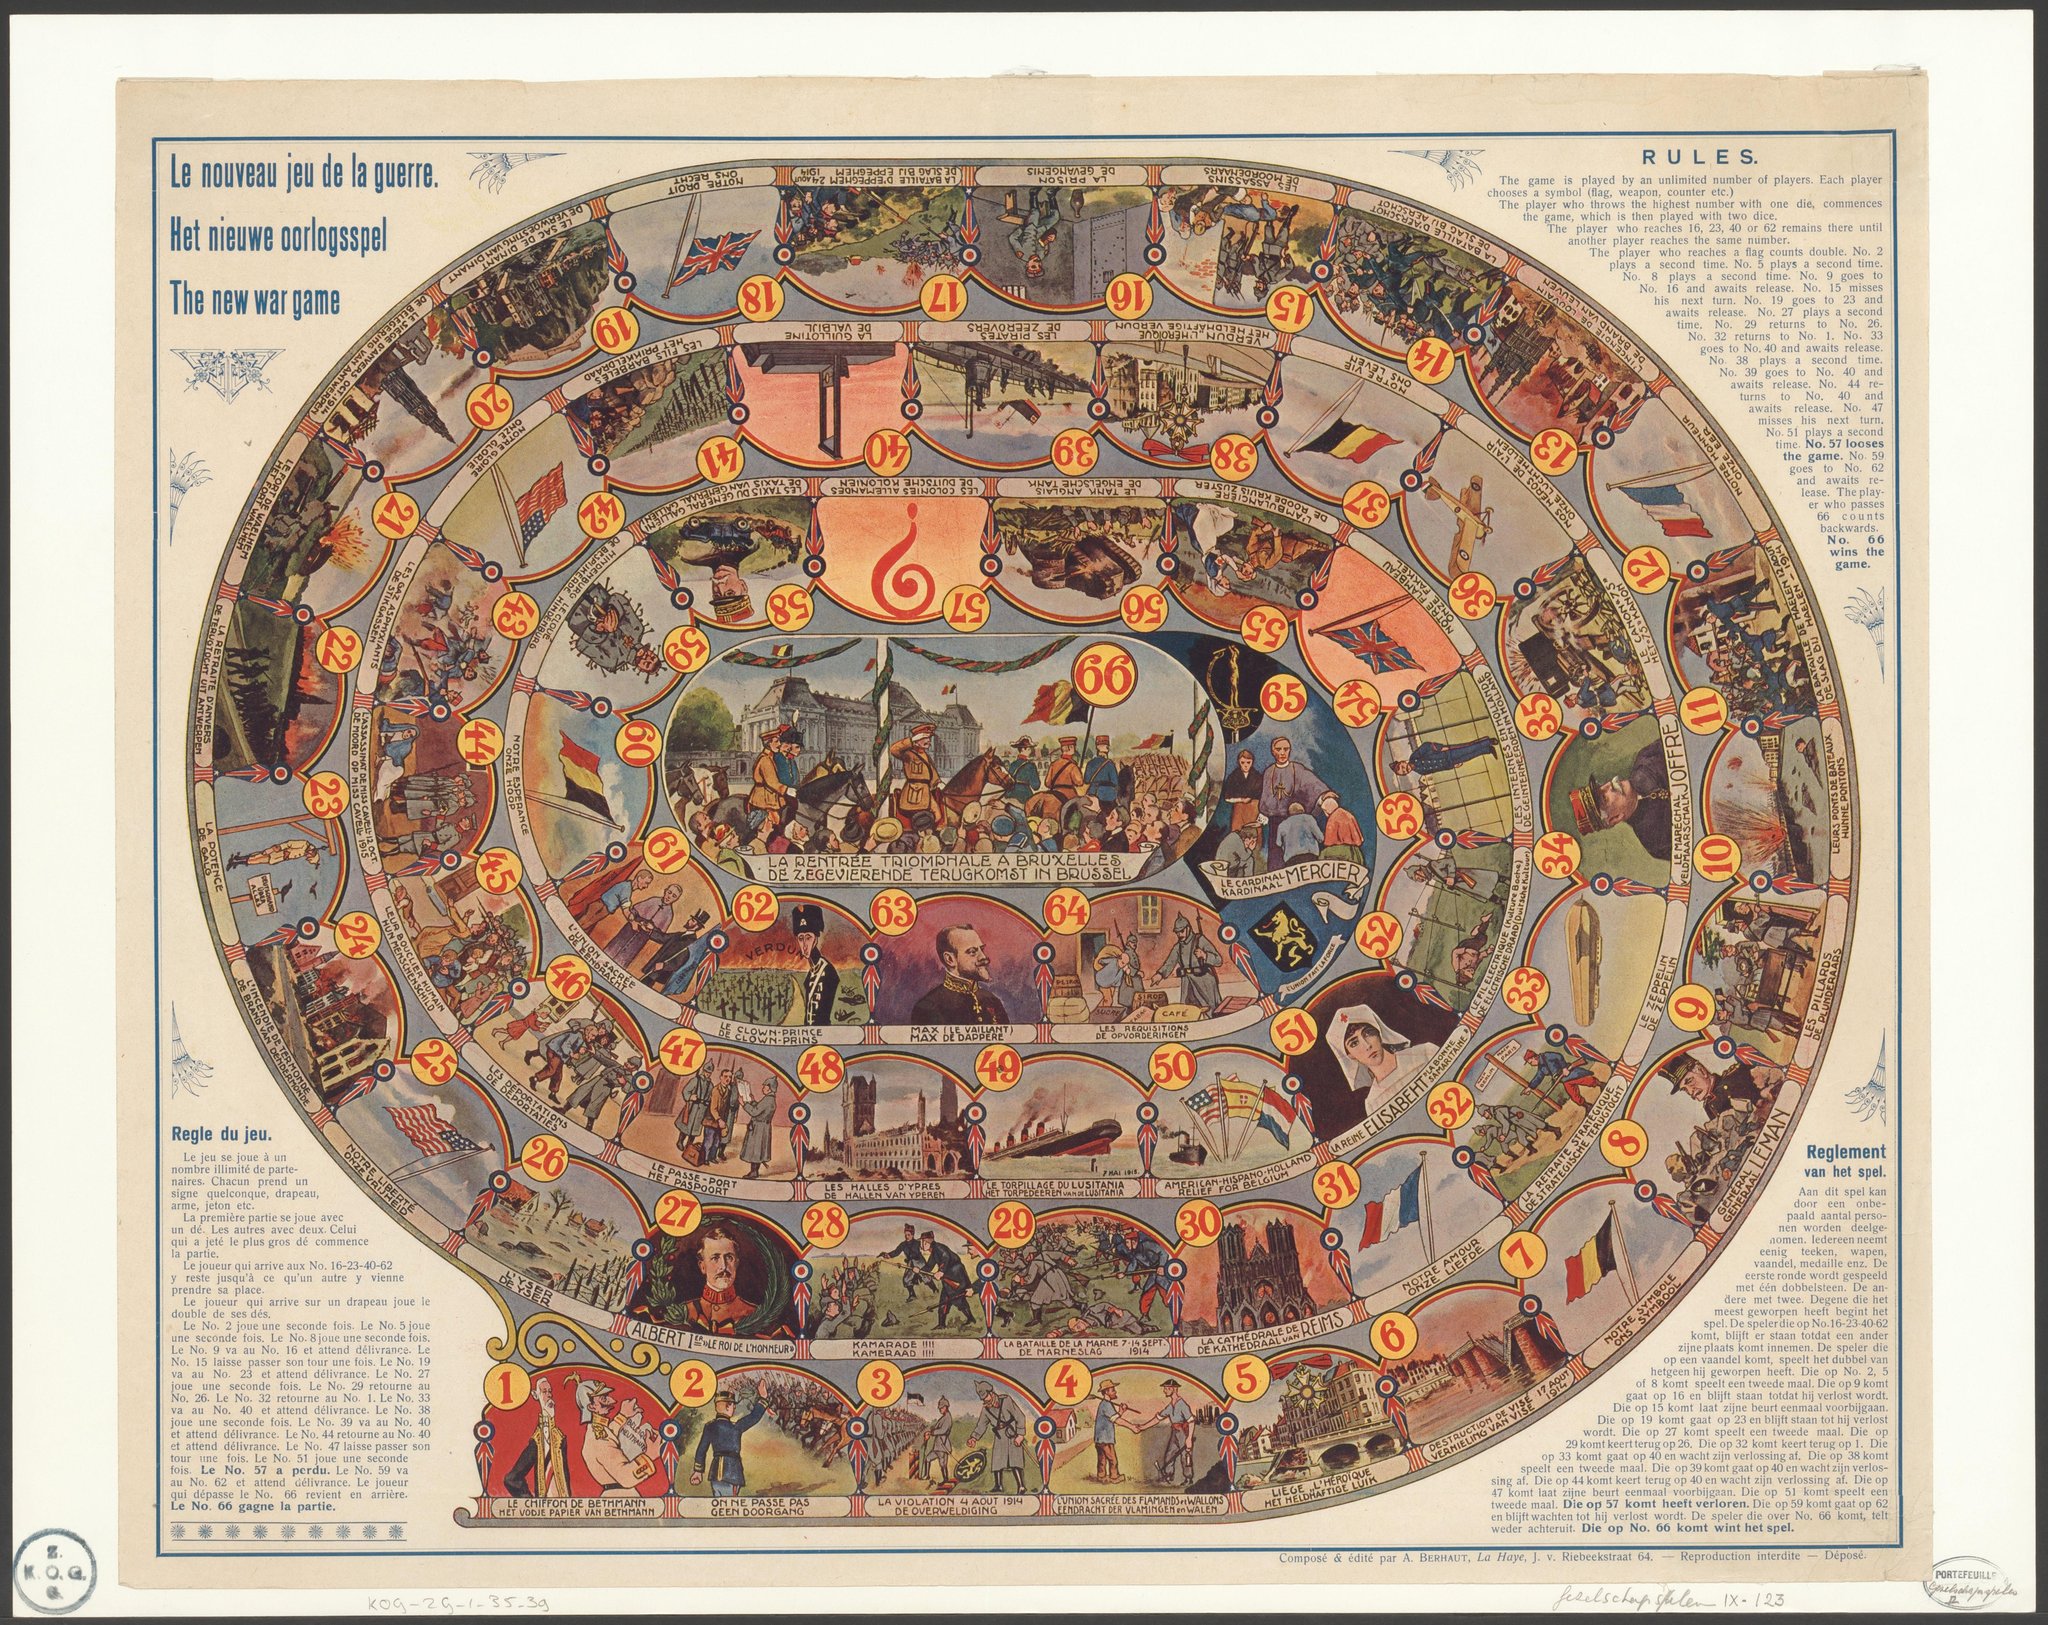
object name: gameboard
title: Le nouveau jeu de la guerre / Het nieuwe oorlogsspel / The new war game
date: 1918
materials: paper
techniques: color autotype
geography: the hague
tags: board-games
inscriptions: stamp, collector's mark: Lugt 1641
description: Bordspel met 66 vakken met afbeeldingen die betrekking hebben op de Eerste Wereldoorlog. In het midden een afbeelding van 'de zegevierende terugkomst in Brussel'. De teksten onder de vakken zijn in het Nederlands en in het Frans. In de hoeken de spelregels in het Nederlands, Frans en Engels. Onderwerpsrubrieken binnen de Atlas Zeden en Gewoonten: Zeden en gewoonten in engeren zin, Spel en vermaak, Gezelschapsspel II, Ganzenbord en dergelijke.